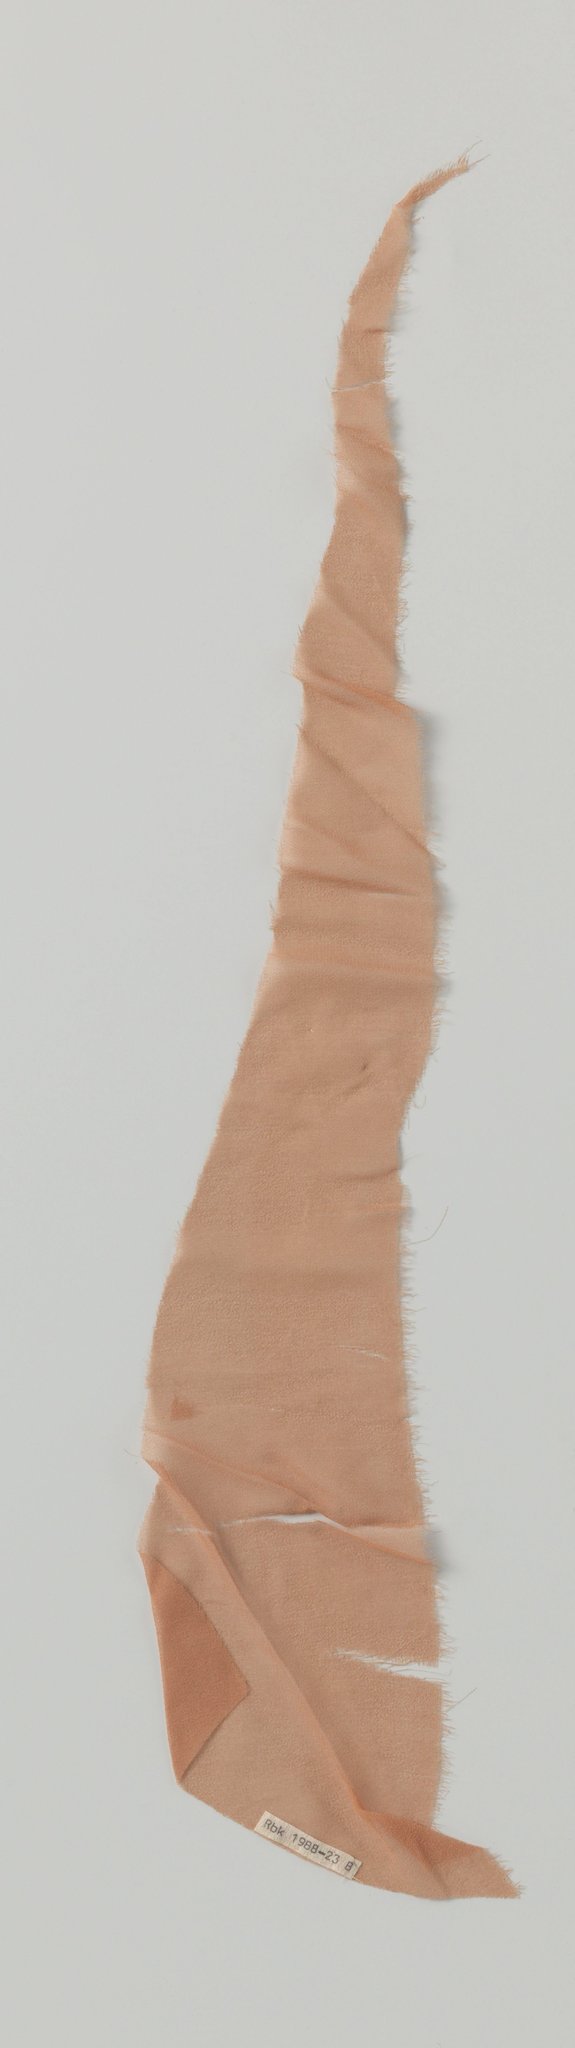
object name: silk textile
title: Fragment oranje zijdeweefsel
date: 1400-1950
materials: silk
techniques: weave